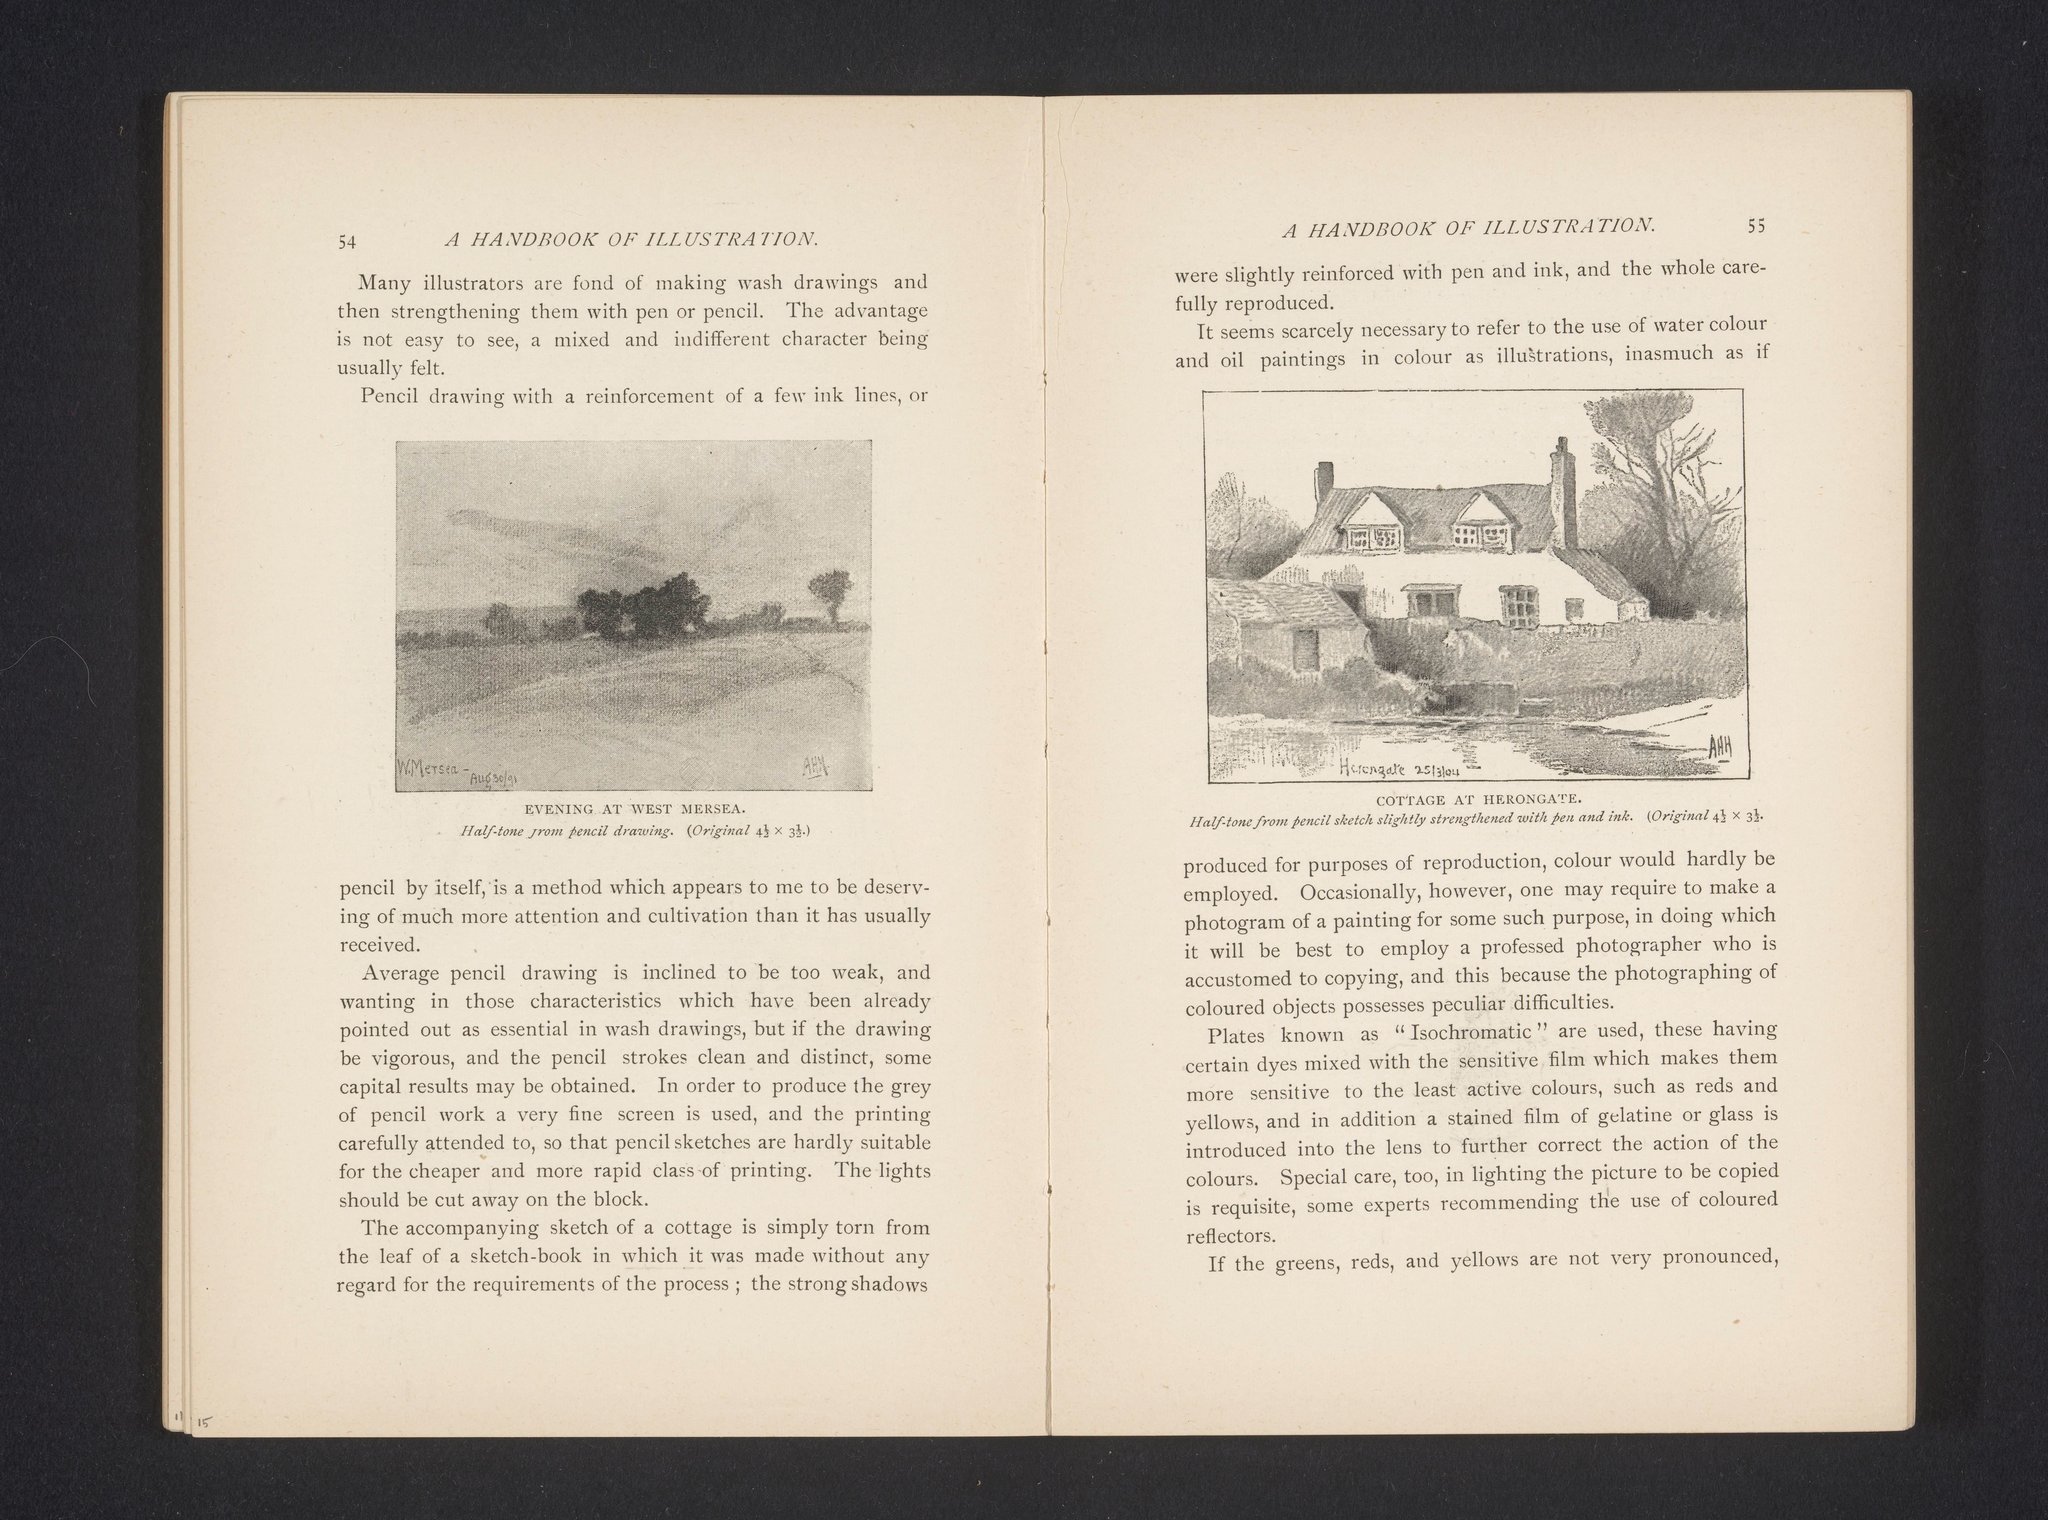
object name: page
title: Fotoreproductie van een tekening van een huis in Herongate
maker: Anonymous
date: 1884-1894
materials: paper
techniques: autotype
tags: cottage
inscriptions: inscription: ‘Half-tone from pencil sketch slightly strengthened with pen and ink. (Original 4 1/2 x 3 1/2.)’, name: ‘Herongate 25/3/04 AHH.’